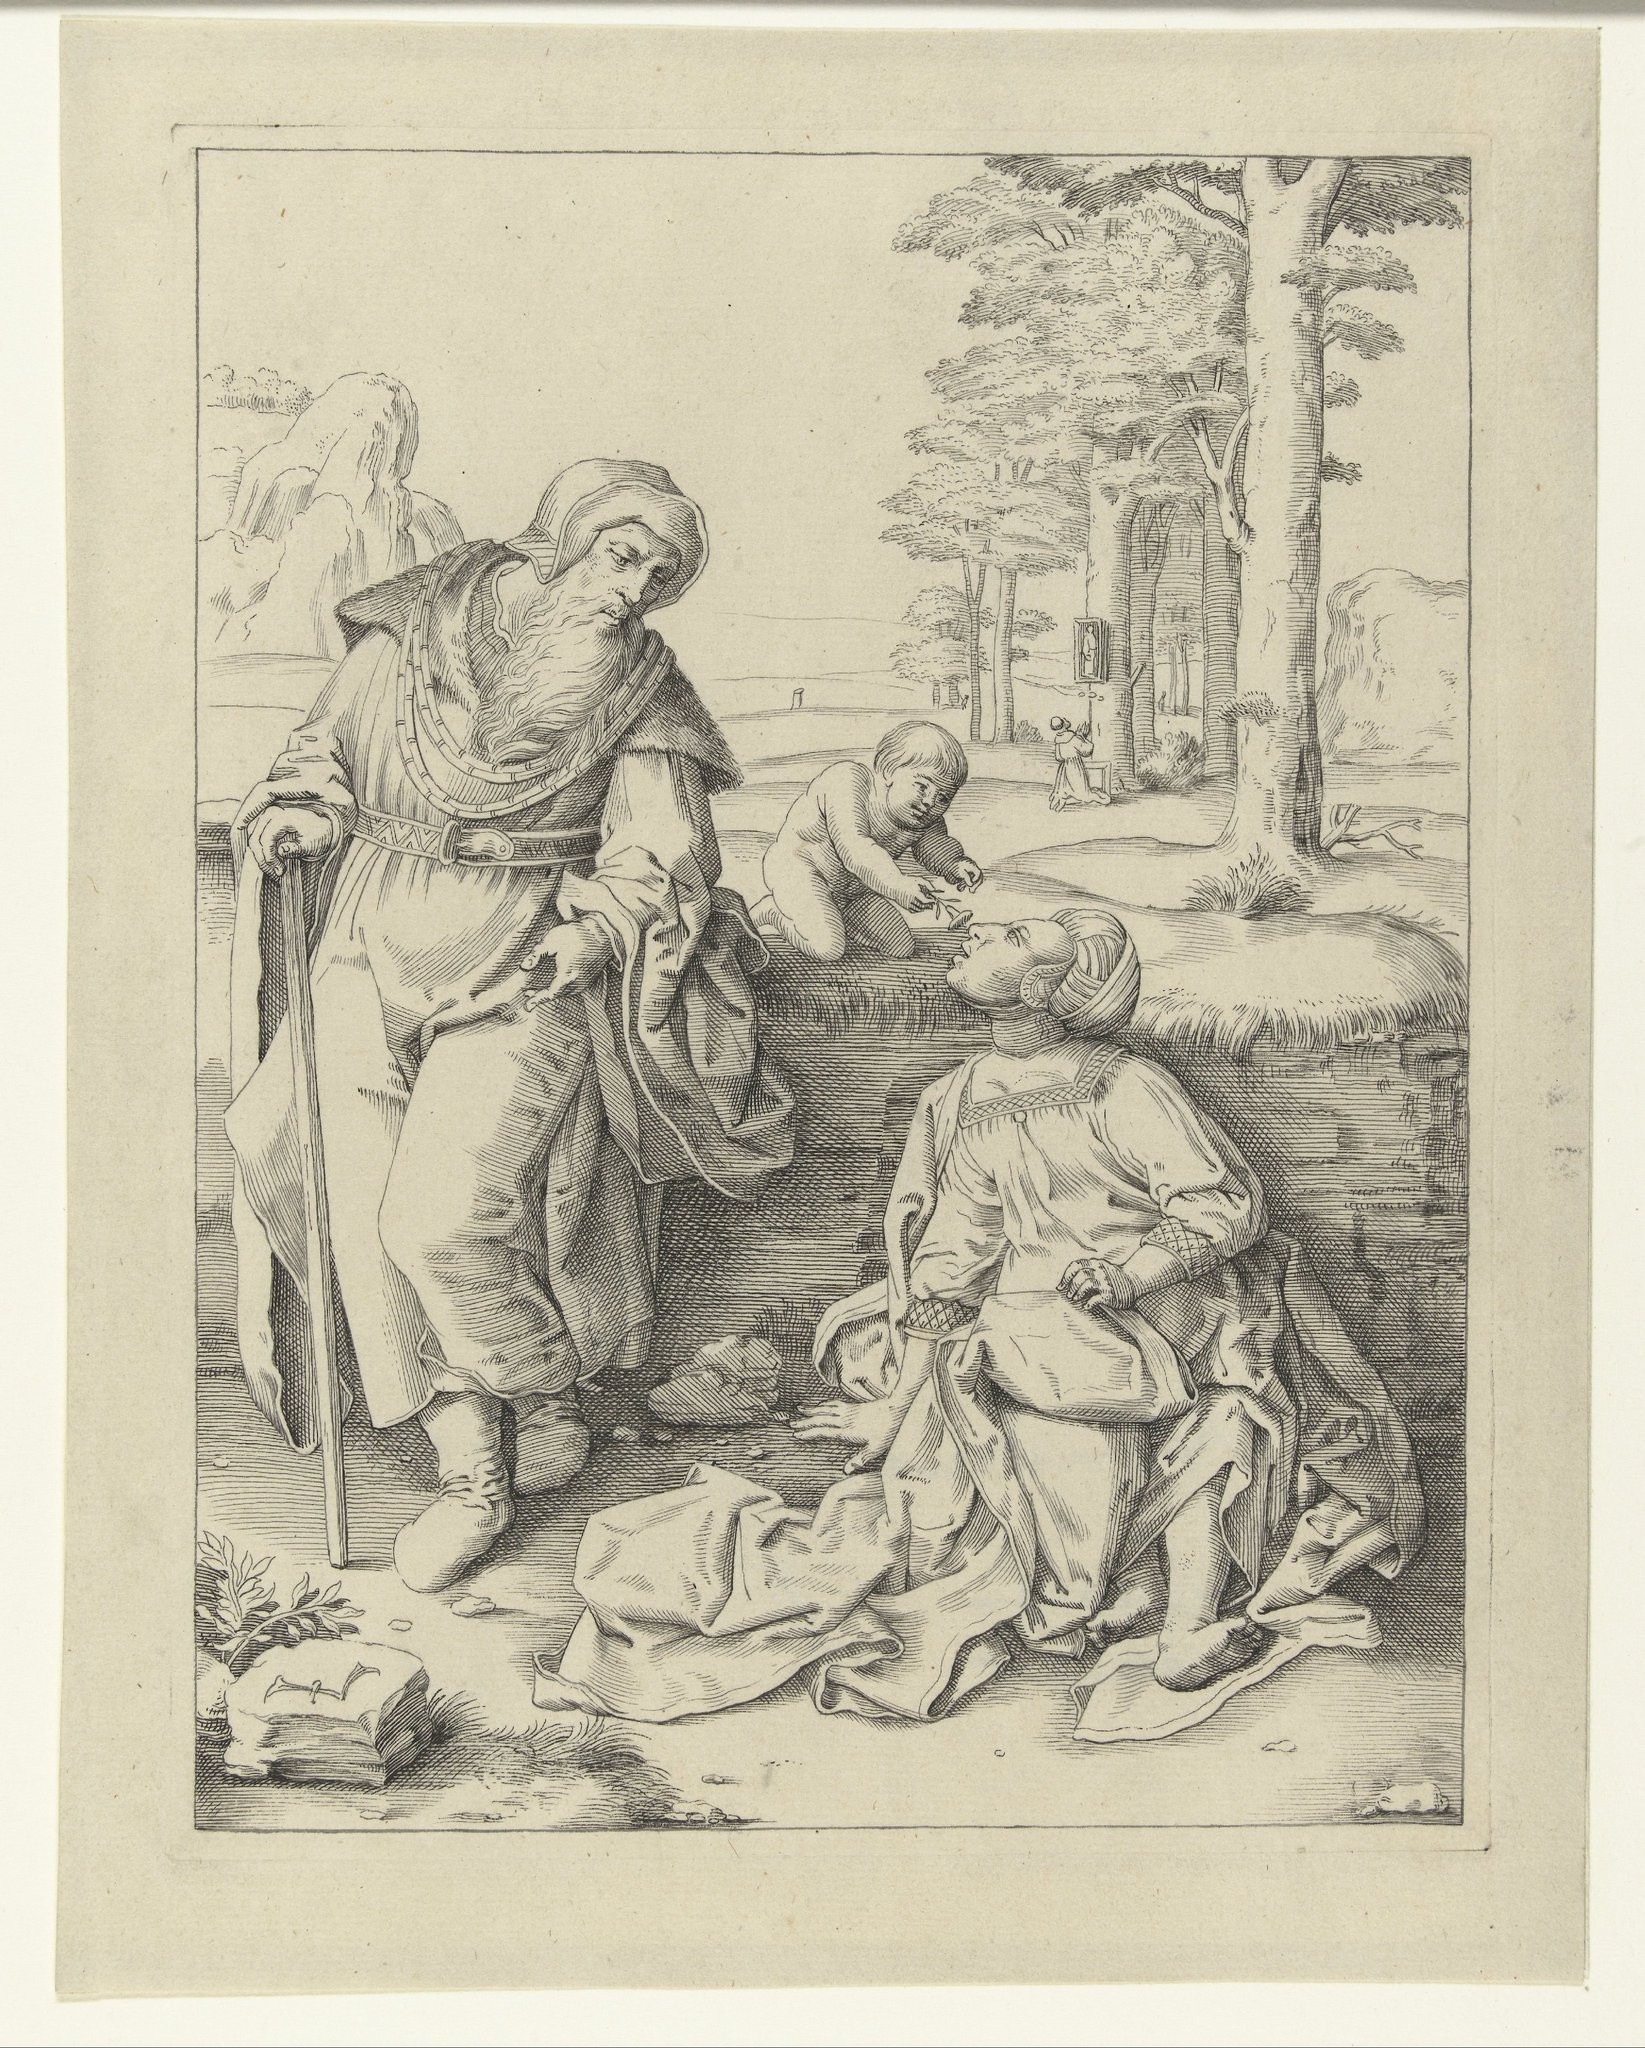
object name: drawing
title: De heilige familie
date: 1583-1649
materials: paper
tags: holy family (alone), 'trinitas terrestris'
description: Getekende kopie naar prent, met plaatrand erin gedrukt. Heilige familie gekleed als pelgrims.